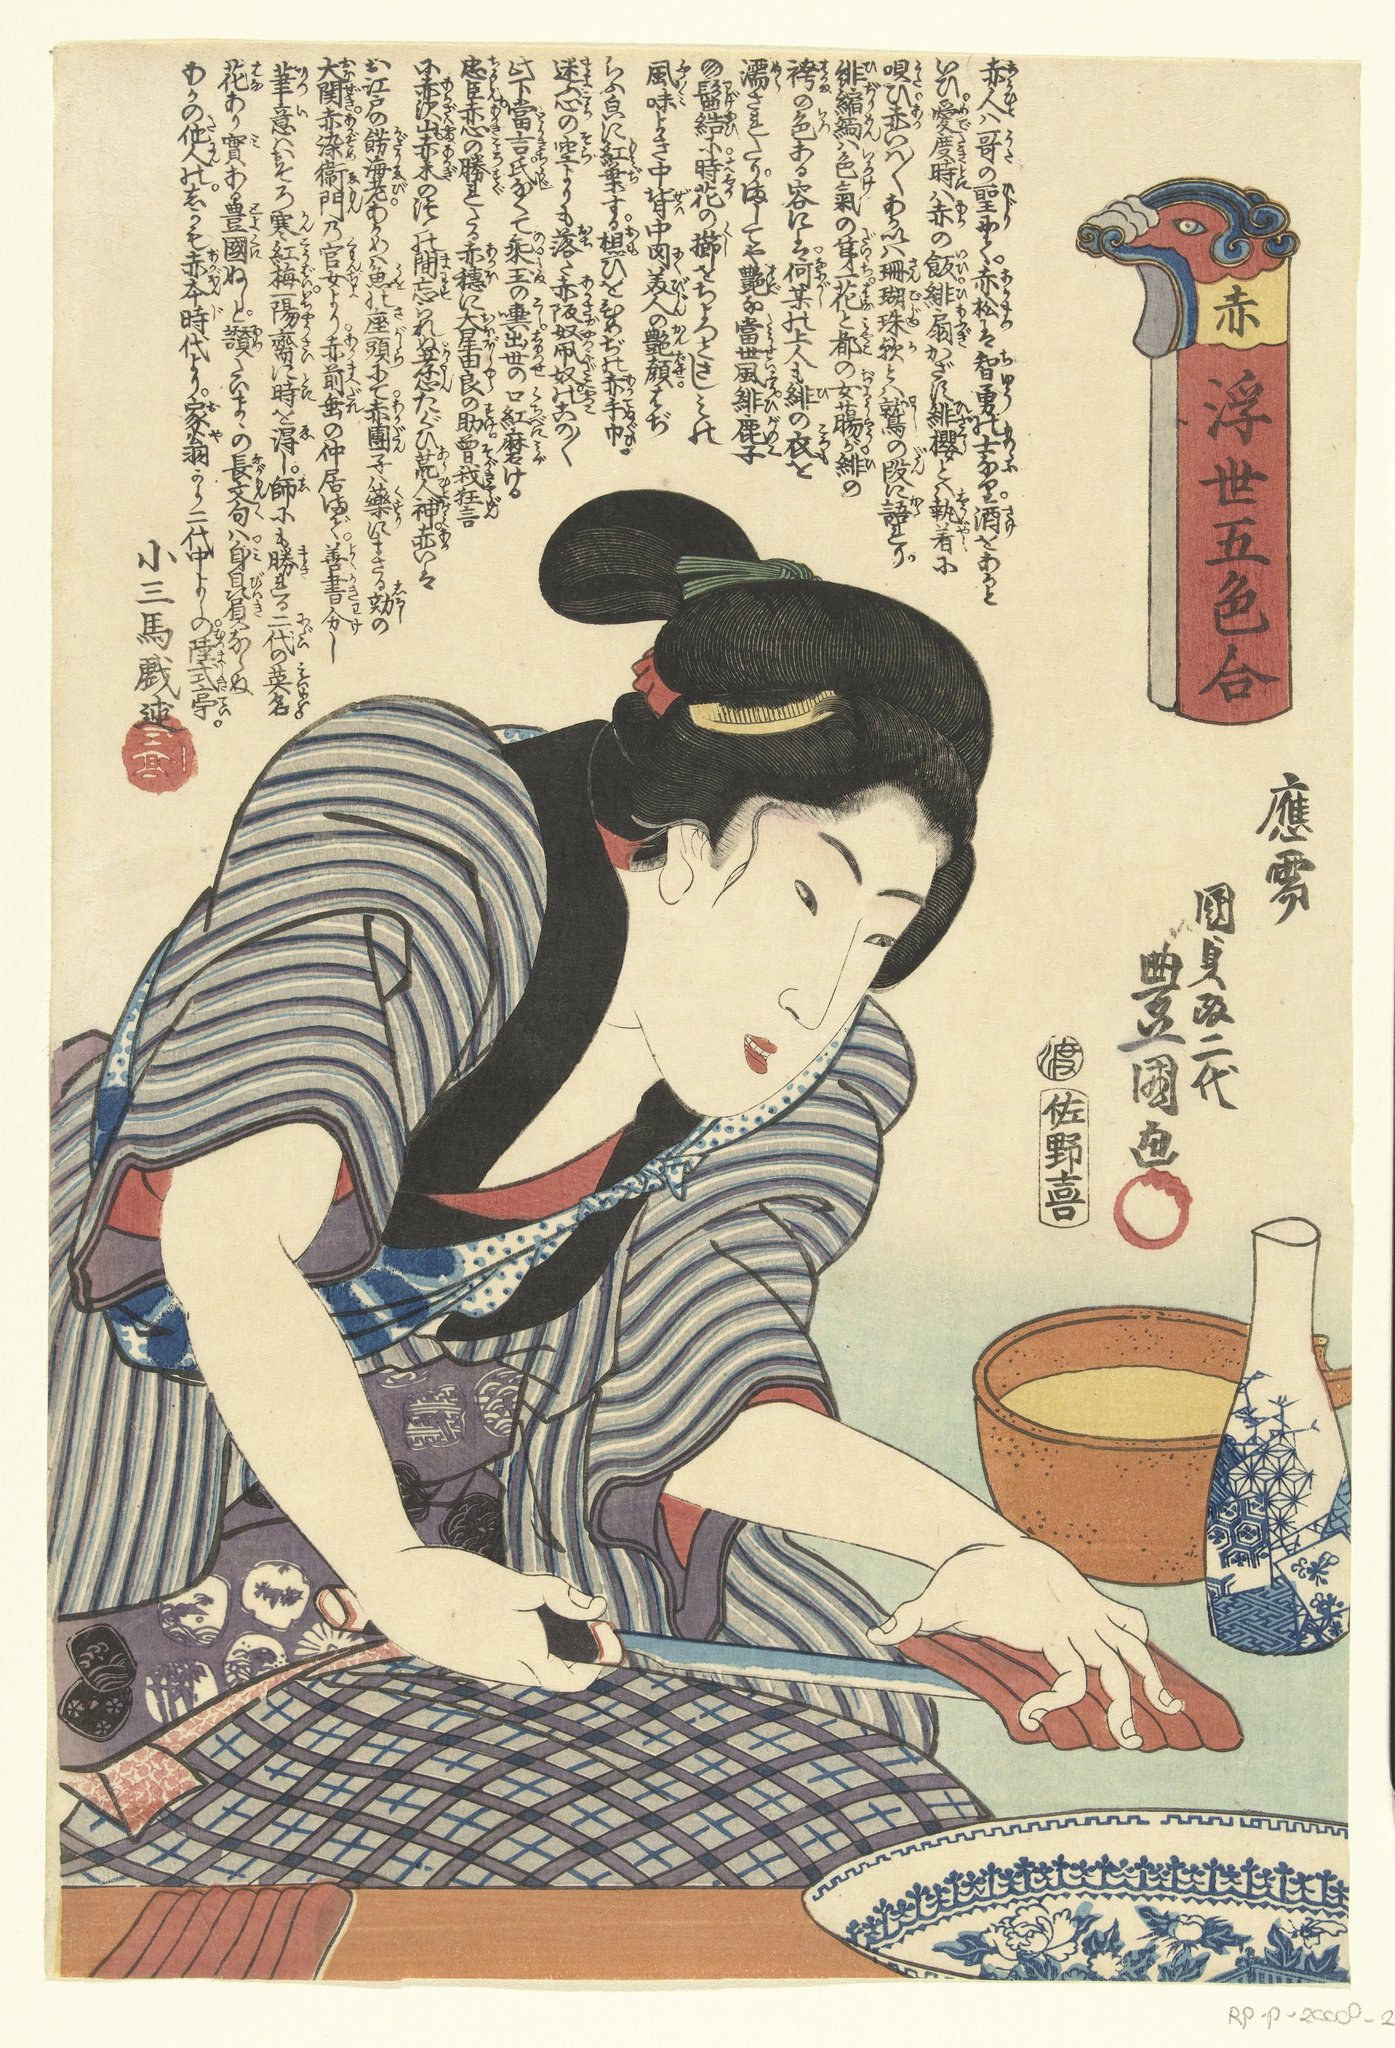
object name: print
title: Ukiyo goshiki awase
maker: utagawa kunisada (i)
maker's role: print maker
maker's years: 1786-1865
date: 1844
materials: paper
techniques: woodcut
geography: tokyo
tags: adult woman, tools, aids, implements ~ crafts and industries: knife, preparation of food